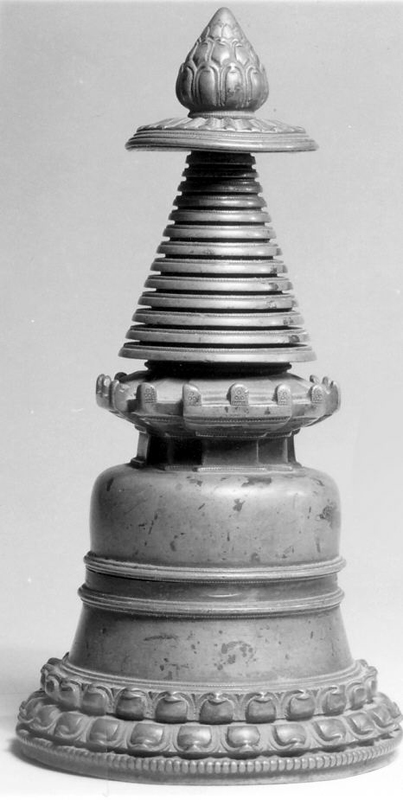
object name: stupa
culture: tibetan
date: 1101-1200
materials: brass